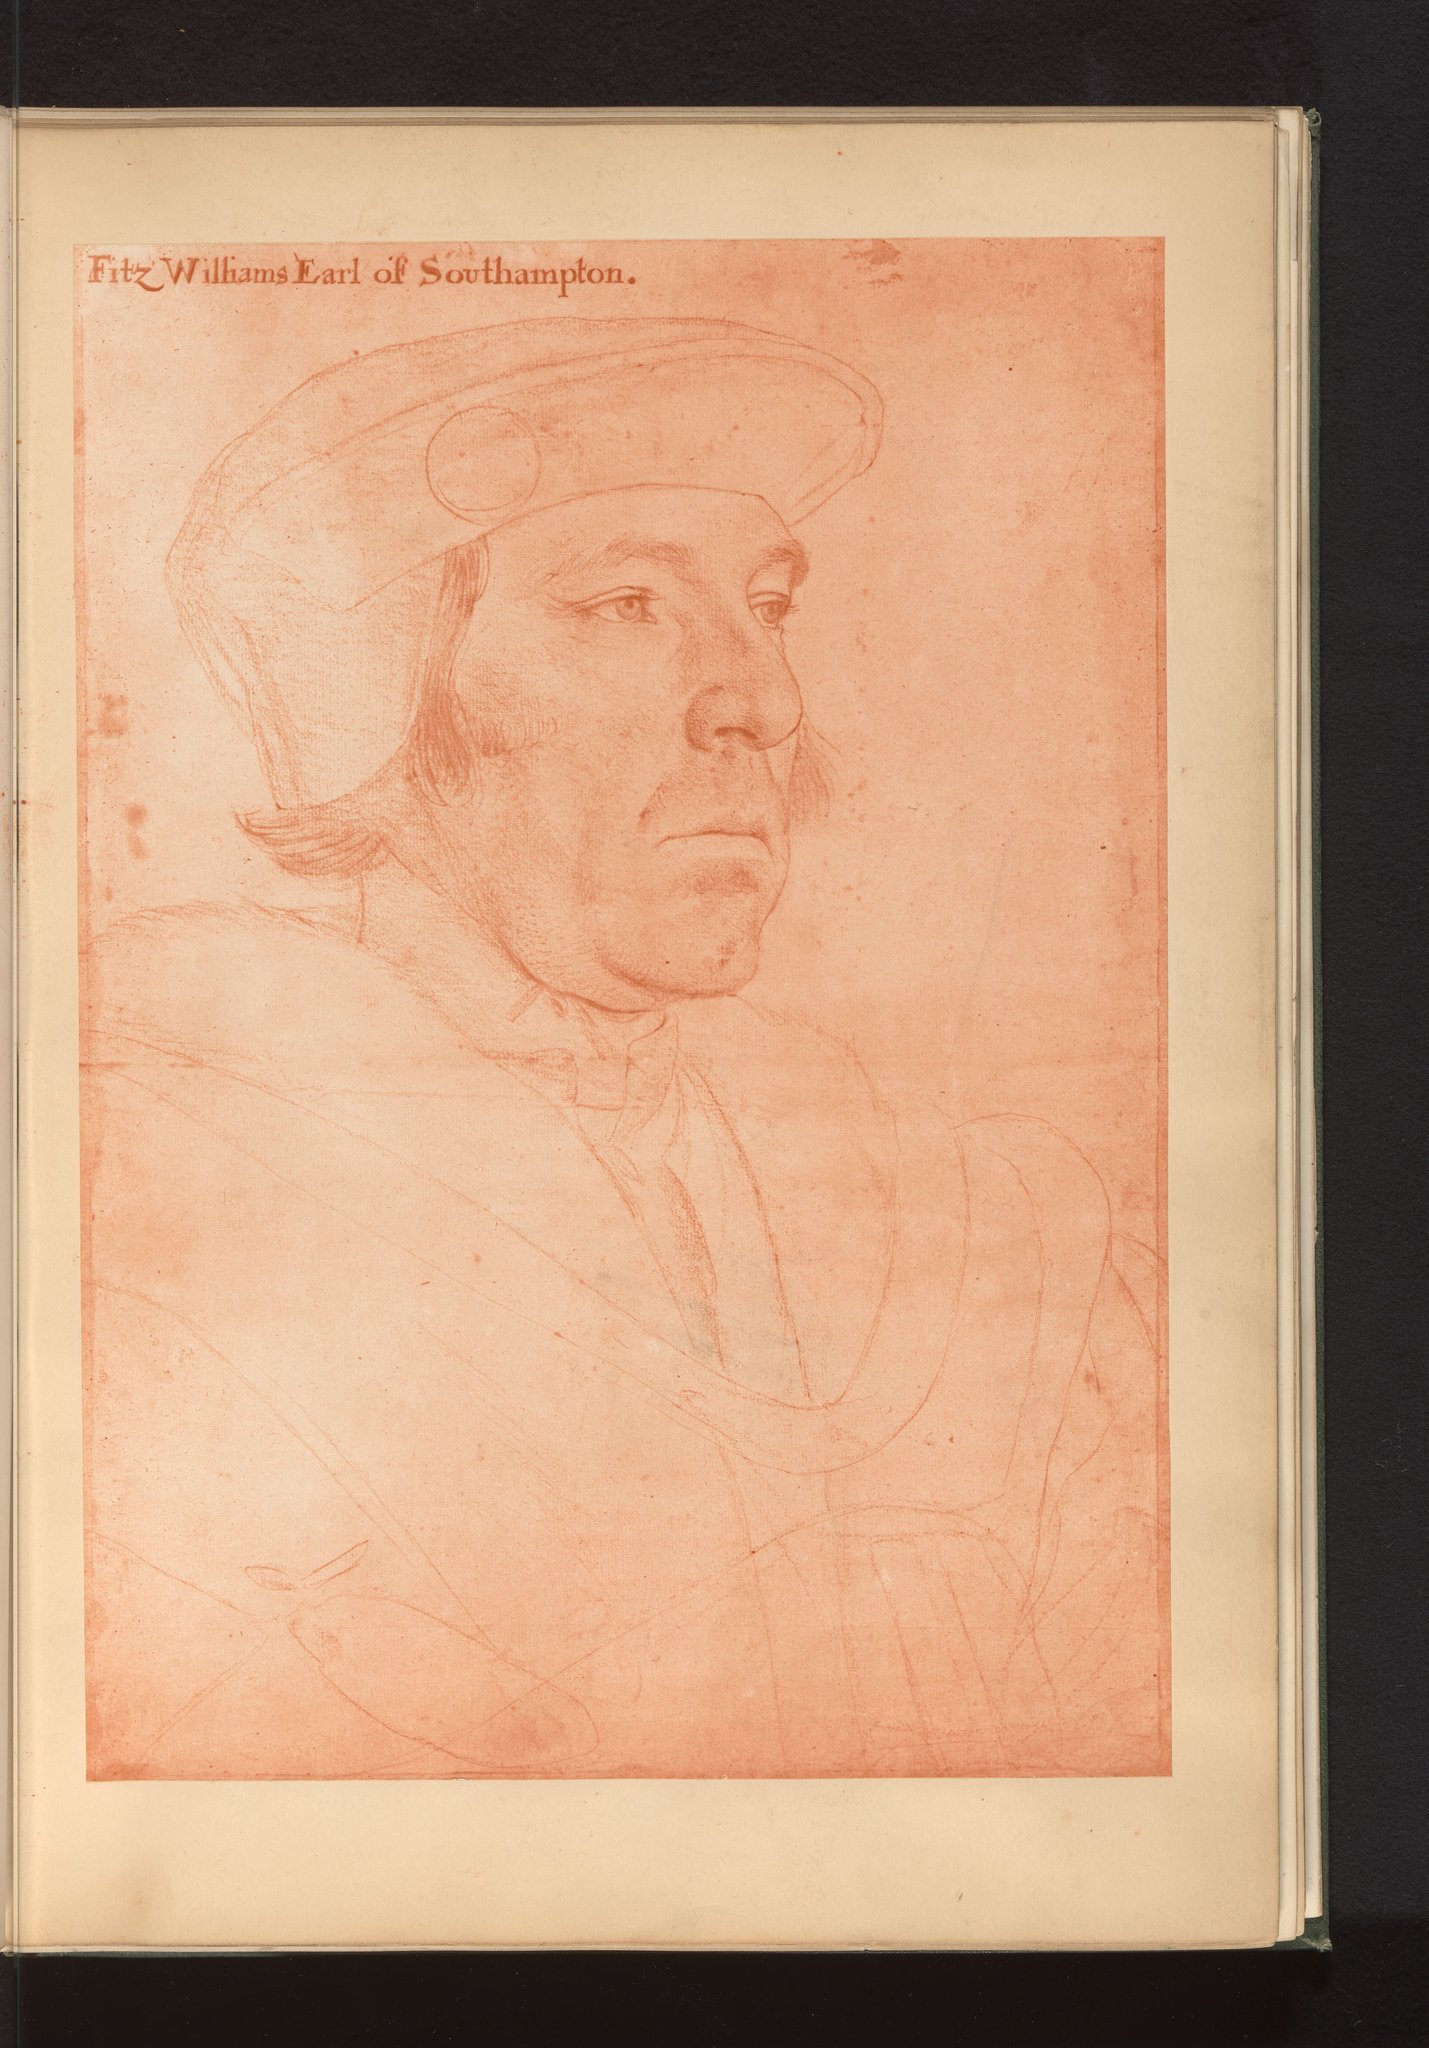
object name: page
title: Fotoreproductie van een portret van William FitzWilliam, graaf van Southampton, door Hans Holbein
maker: Anonymous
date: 1872-1877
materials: paper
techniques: carbon print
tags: drawing, sketch, historical persons, diplomacy, diplomat